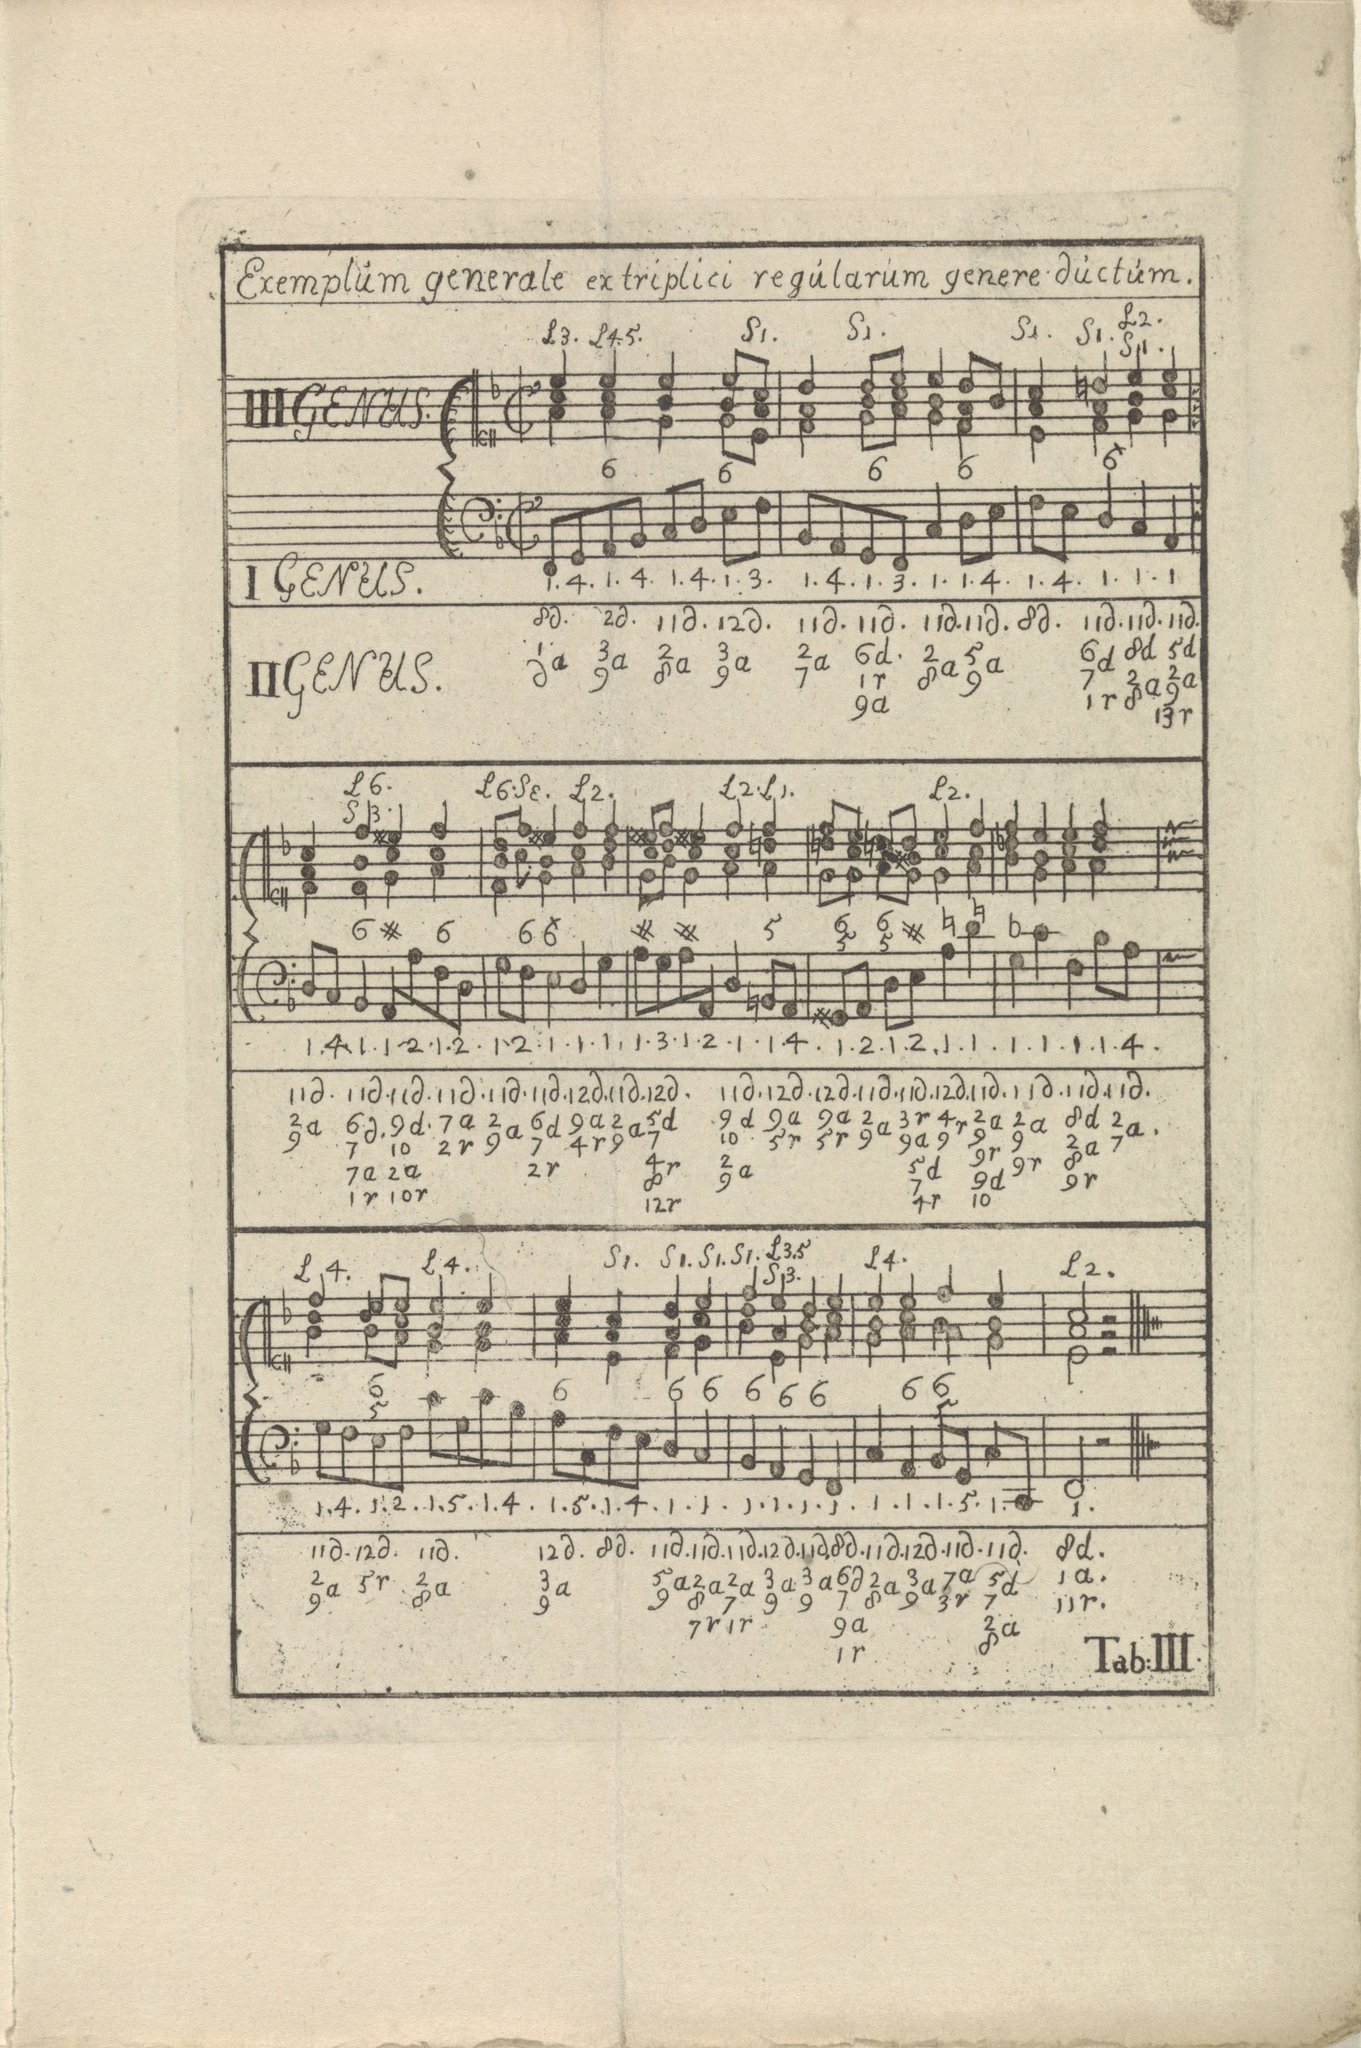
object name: print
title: Bladmuziek Tab. III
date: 1743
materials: paper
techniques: etching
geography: netherlands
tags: notation of music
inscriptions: collector's mark: Lugt 2760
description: Bladmuziek uit: Konrad Zumbach von Coesfeld, Institutiones musicæ, of Korte onderwyzingen rakende de practyk van de musyk; en inzonderheid van den generaalen bas [...] benevens de [...] gronden van de compositie, 1743. Rechtsonder: Tab. III.